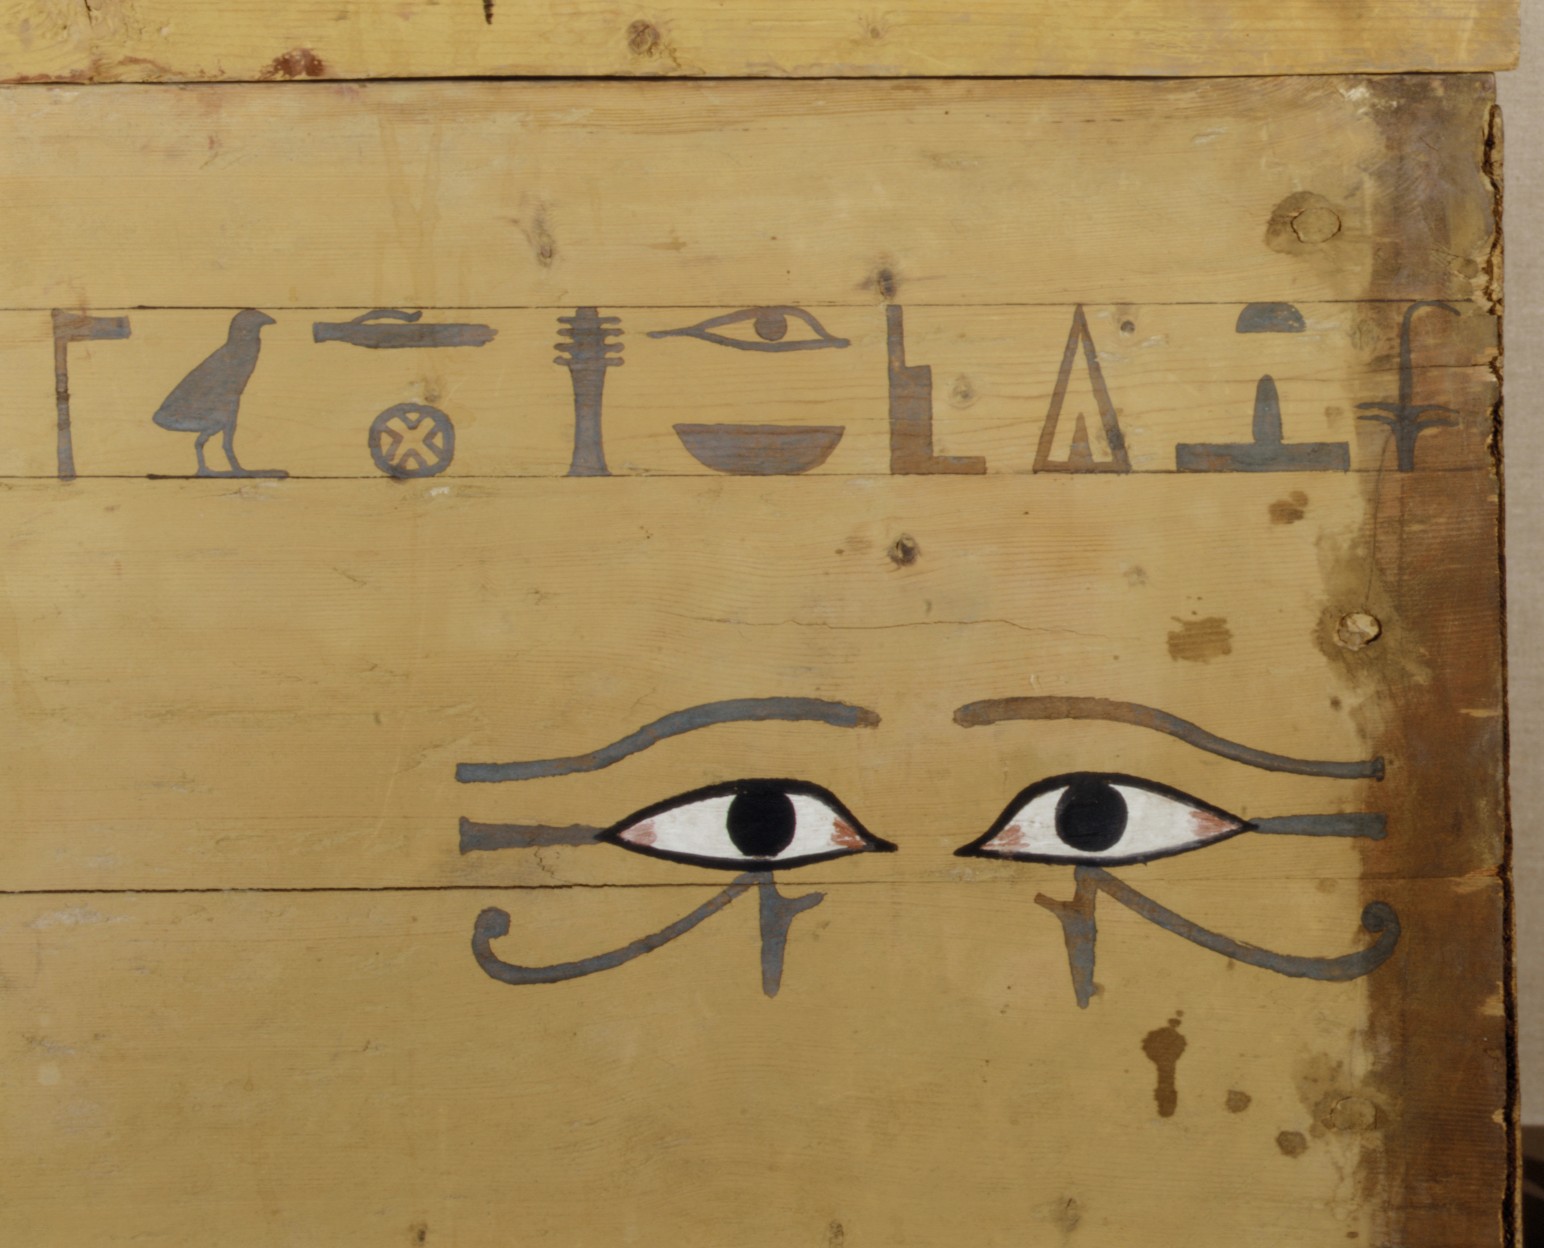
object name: coffin, wah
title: Coffin of Wah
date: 1981-1975 BCE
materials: paint, wood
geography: egypt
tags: eyes,hieroglyphs,coffins